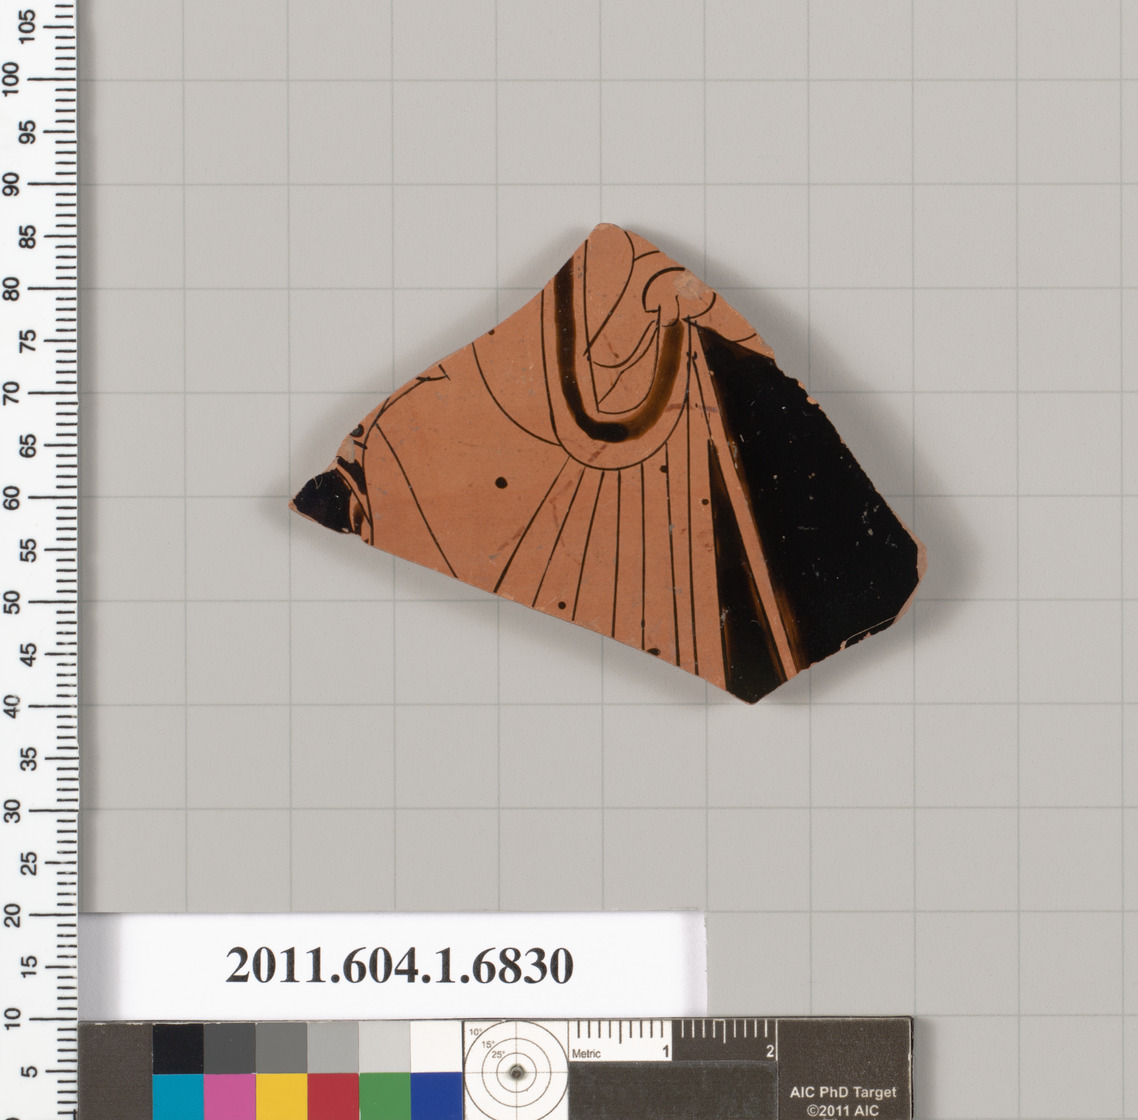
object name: kylix fragment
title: Terracotta fragment of a kylix (drinking cup)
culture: greek, attic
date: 490-470 BCE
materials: terracotta